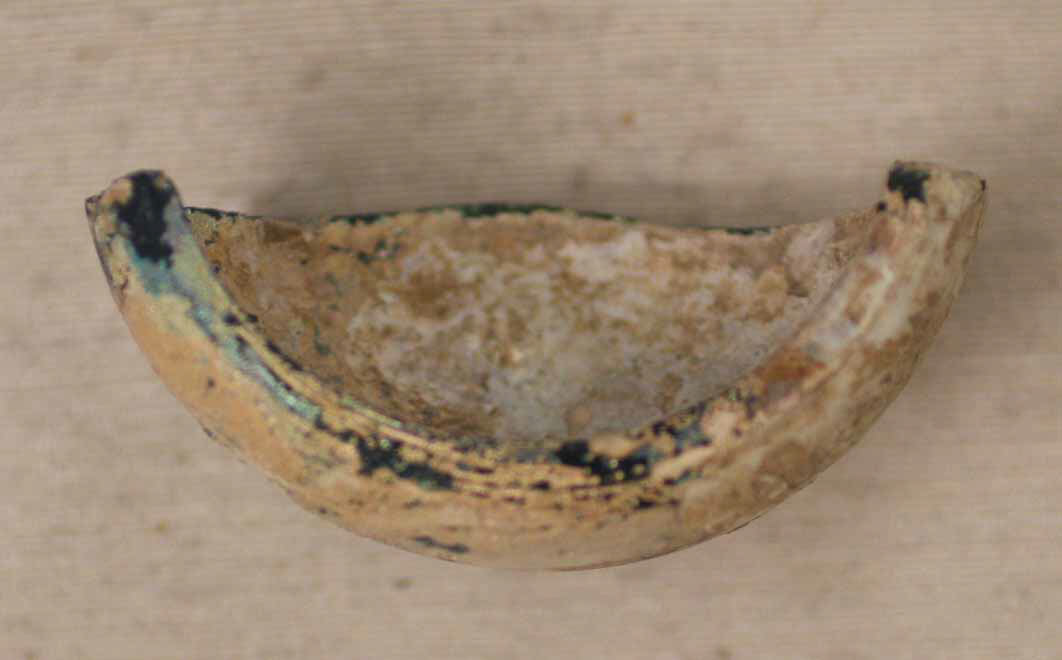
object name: fragment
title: Fragment of a Bowl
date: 701-900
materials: glass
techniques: glassblowing, tooling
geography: iraq